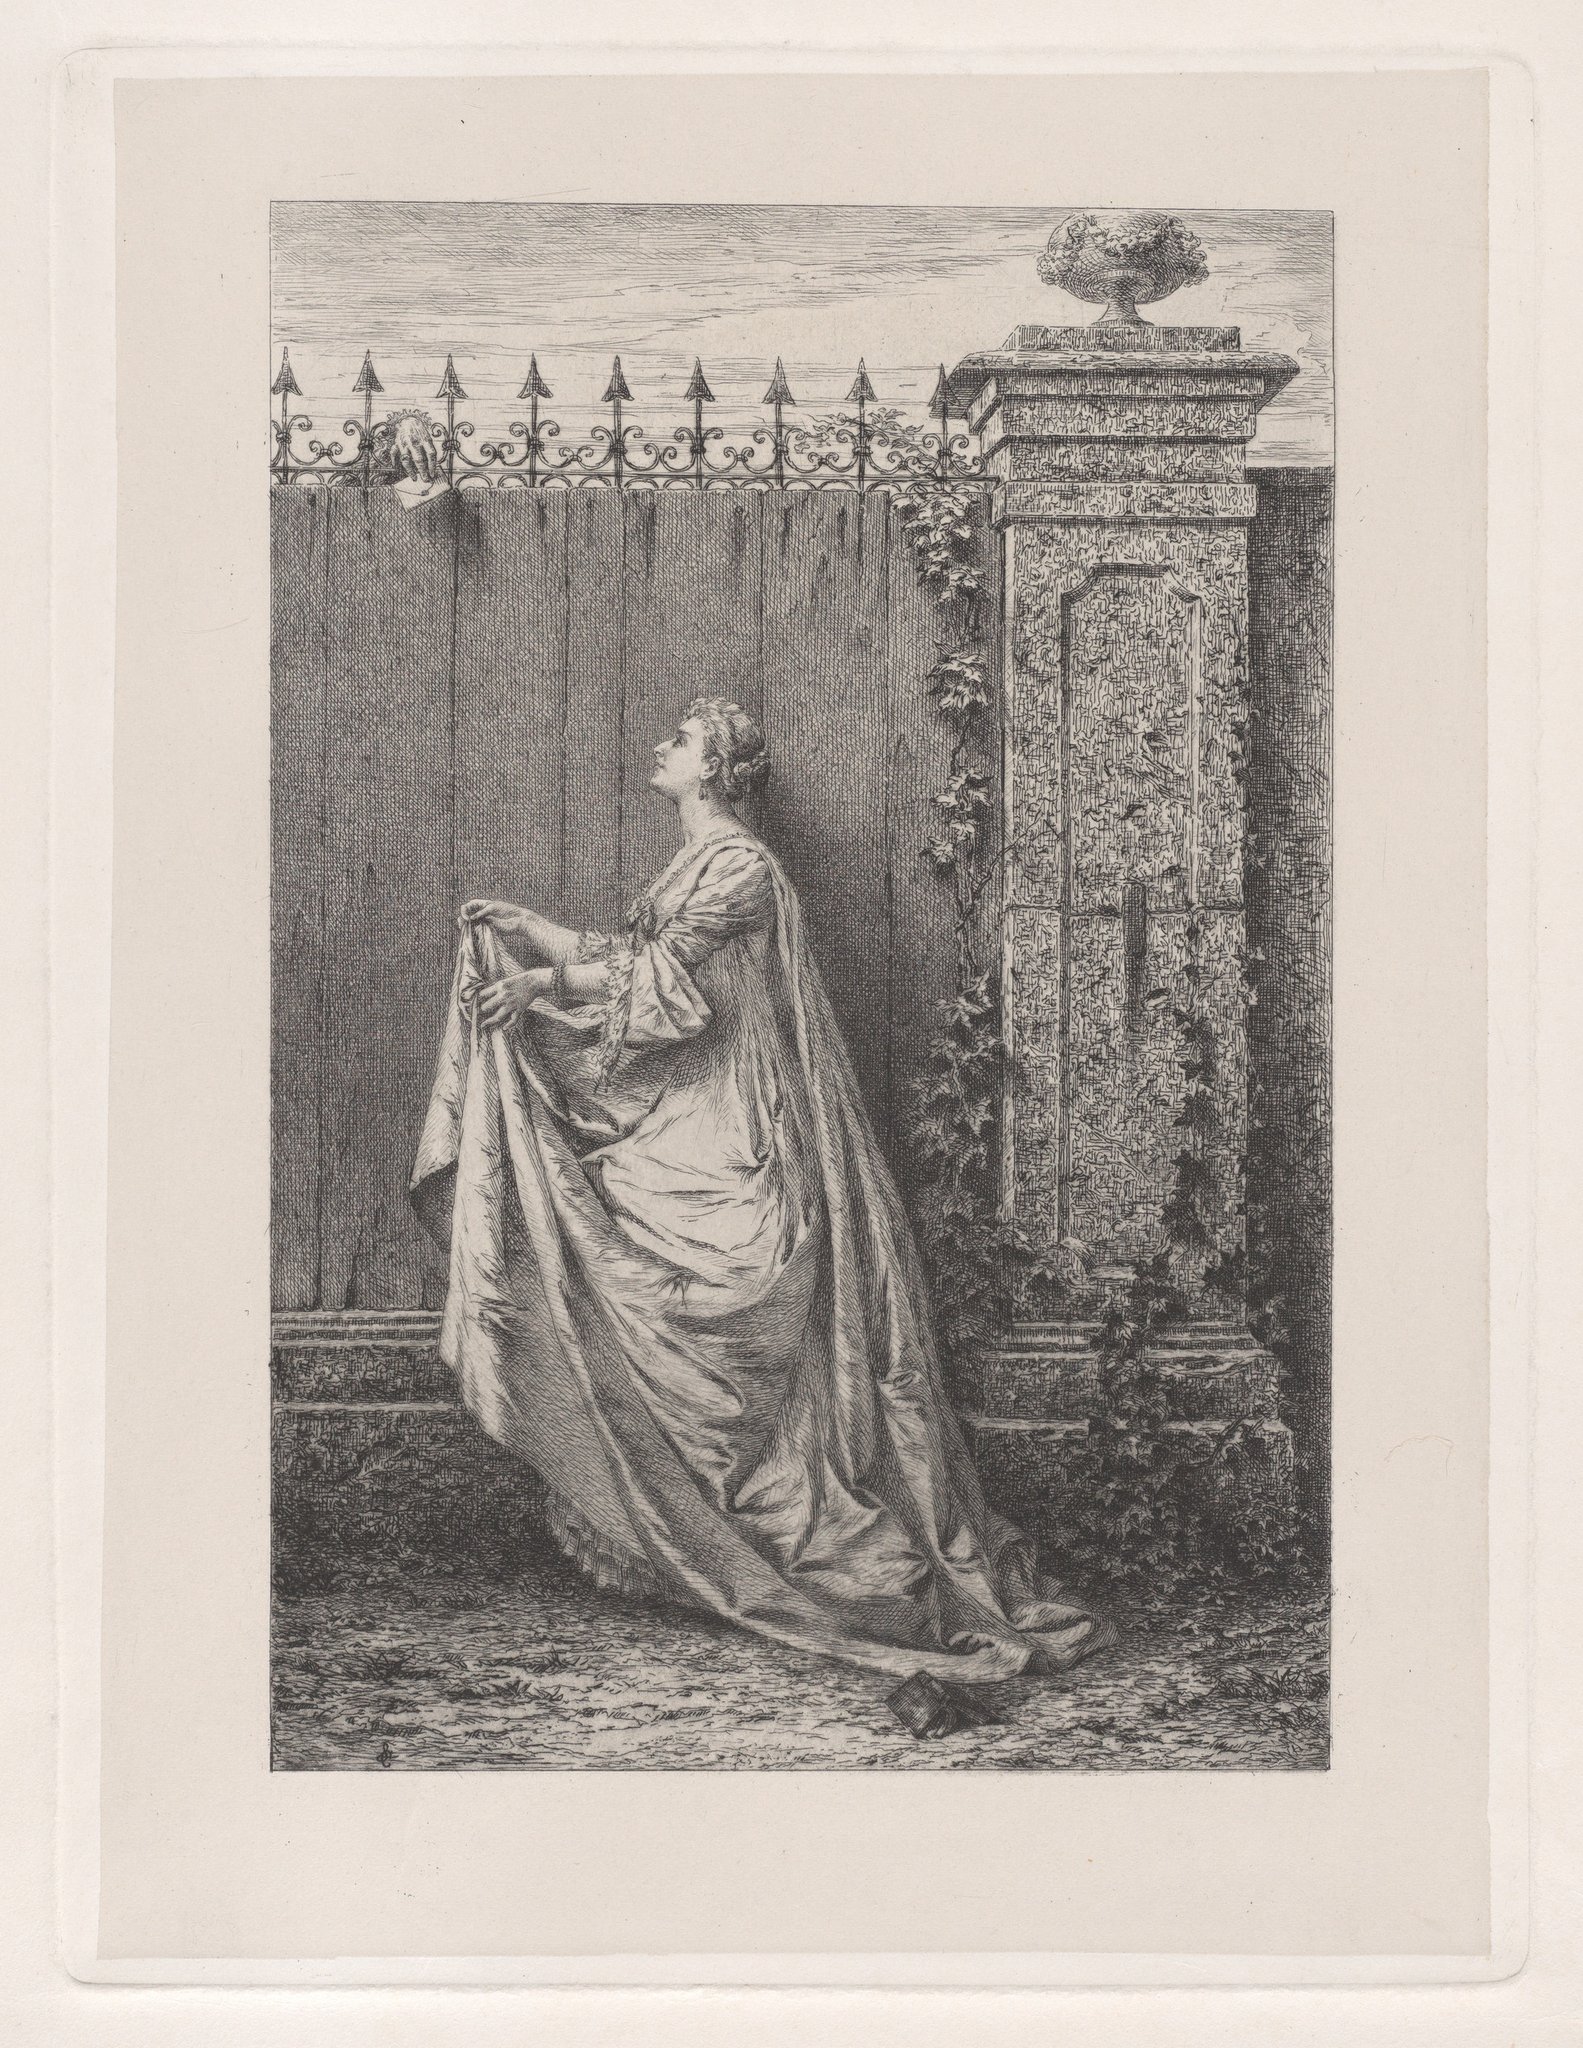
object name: print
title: Furtive message (Messaggio furtivo)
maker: luigi crosio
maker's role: artist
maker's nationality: italian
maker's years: 1835-1915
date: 1870-1871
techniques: etching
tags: women